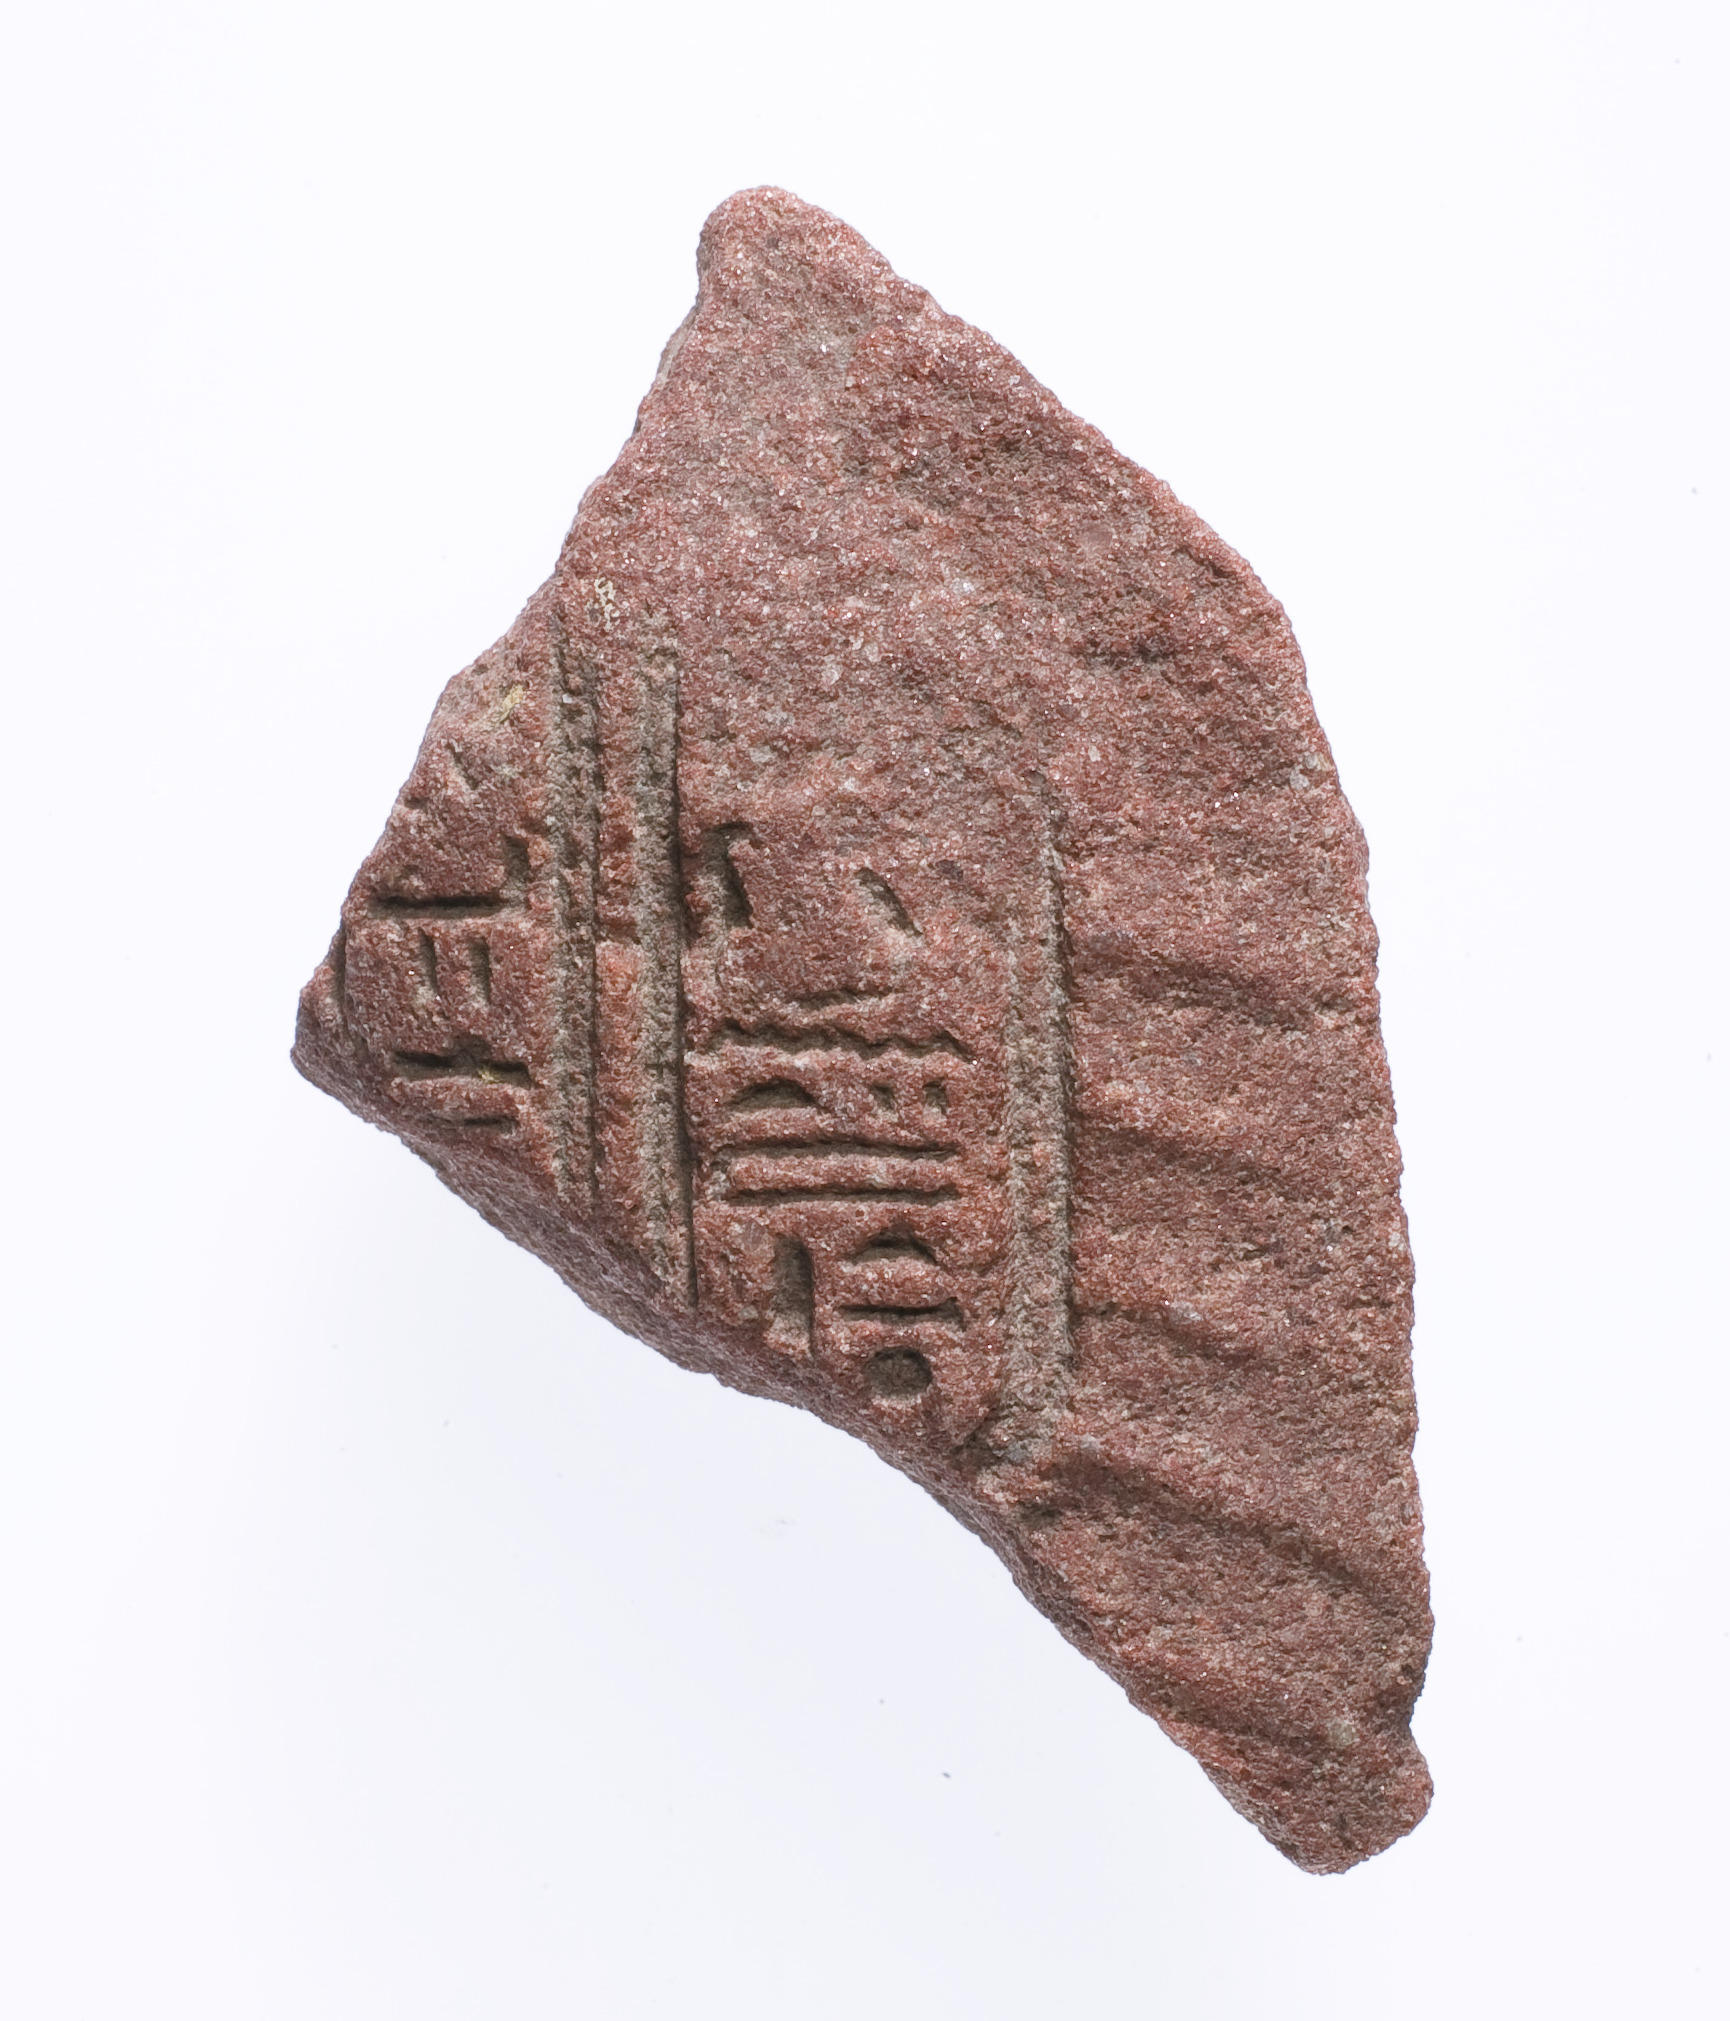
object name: chest with garment, aten cartouch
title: Chest in garment with Aten cartouches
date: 1353-1336 BCE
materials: quartzite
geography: egypt